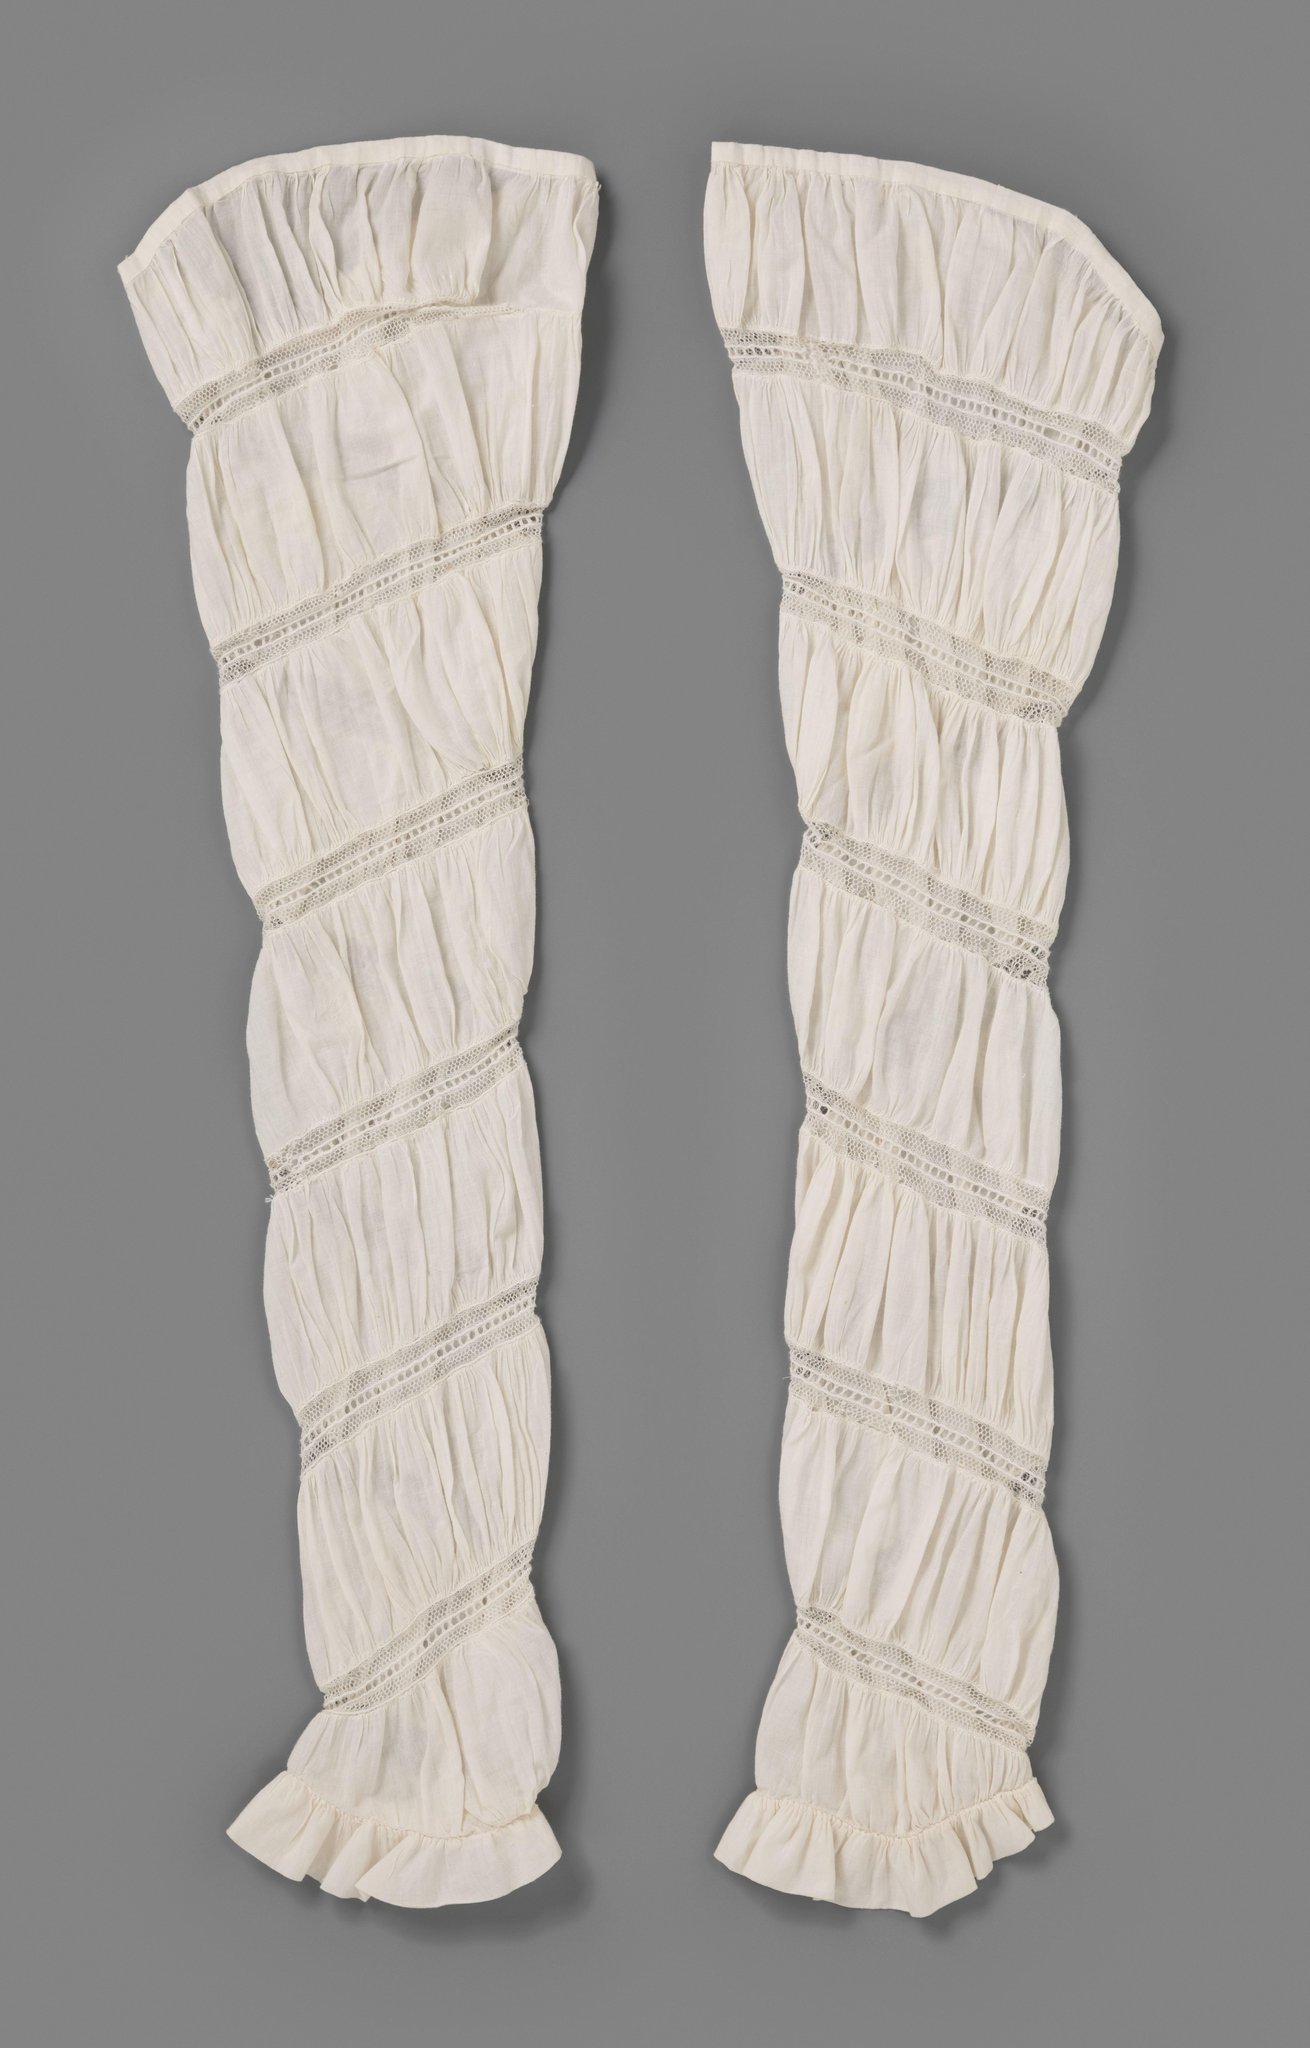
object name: mameluke sleeve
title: Pair of sleeves with spiral-shaped insets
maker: Anonymous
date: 1820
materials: cotton, linen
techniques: embroidered, weave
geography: netherlands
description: These long sleeves are gathered at intervals to make a series of puffs. Called Mameluke sleeves, they became fashionable around 1808. Originally Mamluks were the bodyguards of a sultan. After Napoleon’s campaign through Egypt and Palestine (1798–1801), Arabian influences became increasingly visible in fashion. The inset is made of needlepoint lace, which was produced in Carrickmacross, Ireland, from 1820.